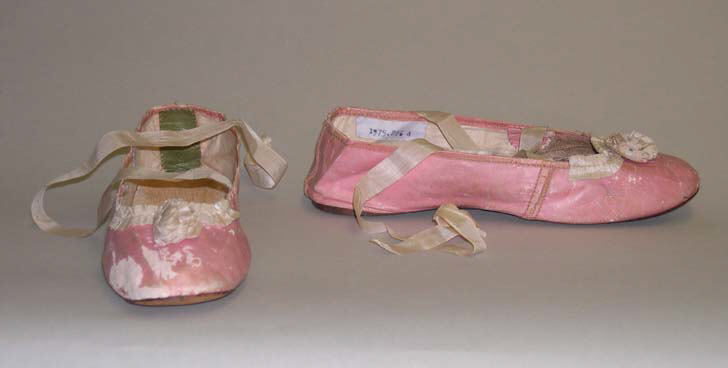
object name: shoe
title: Shoes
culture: american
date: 1812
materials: leather, silk